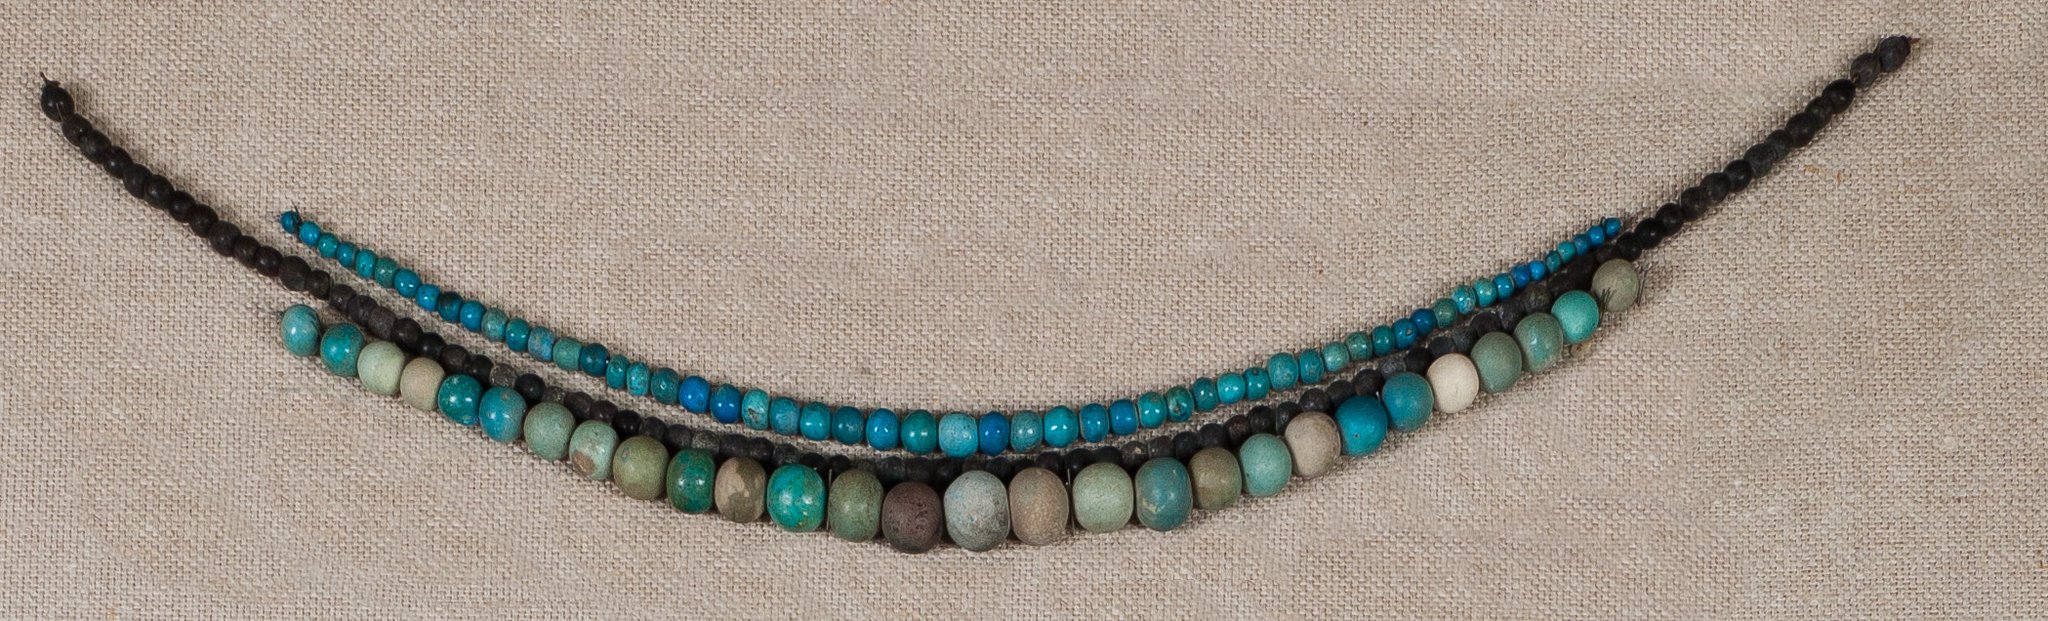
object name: necklace, bead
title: String of beads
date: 1981-1295 BCE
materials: faience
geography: egypt